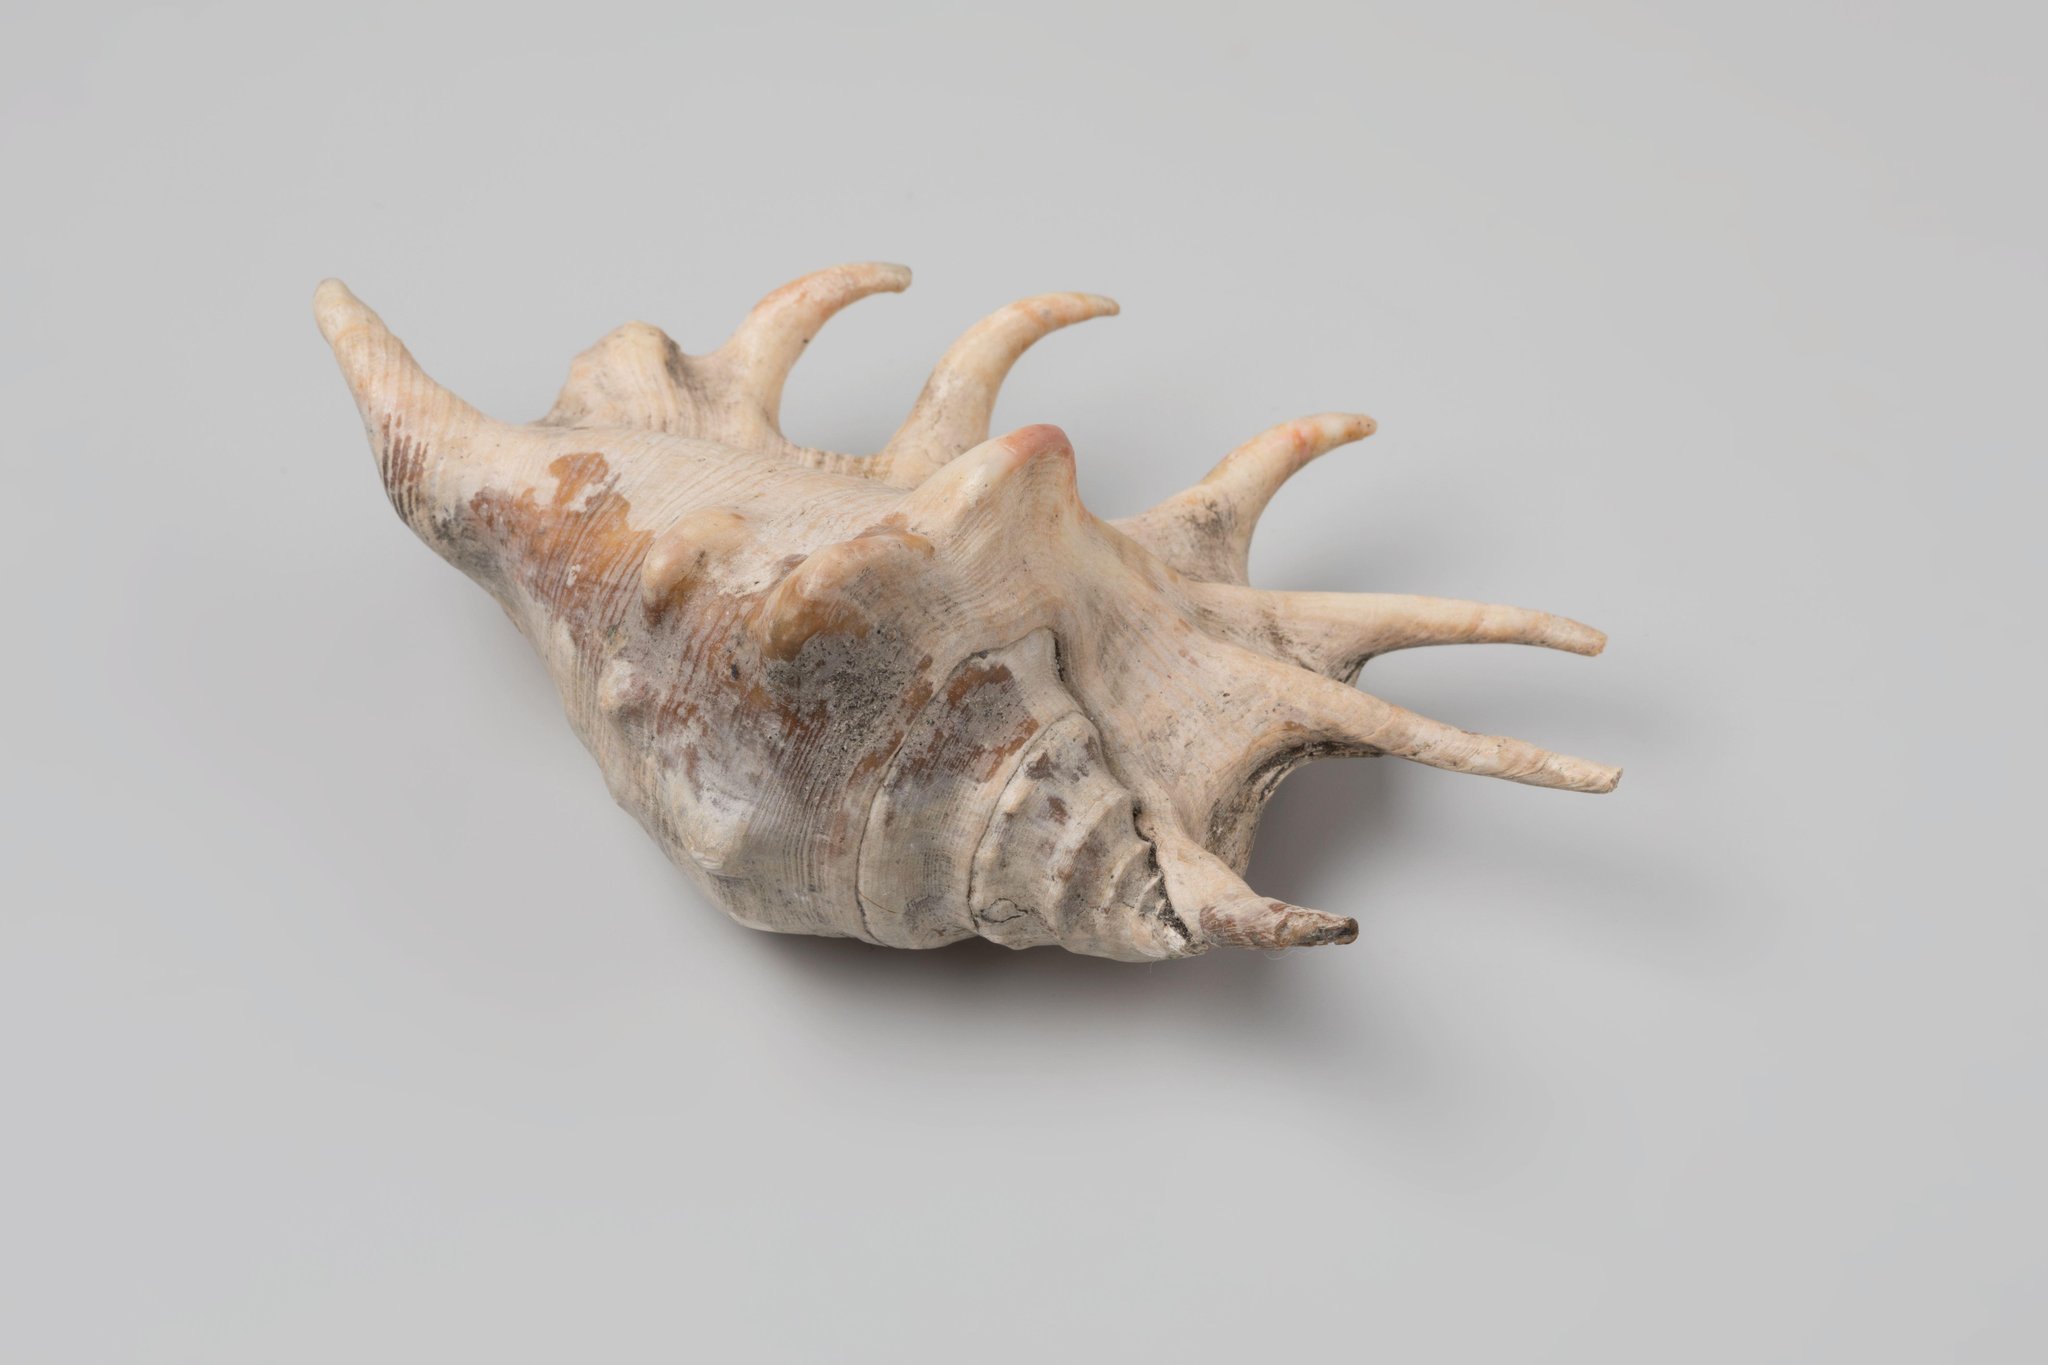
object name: lambis lambis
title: Lambis lambis shell from the wreck of the Dutch East India ship Witte Leeuw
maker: niet van toepassing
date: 1613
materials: shell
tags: verenigde oostindische compagnie, sint-helena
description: Schelp uit V.O.C.-schip de 'Witte Leeuw'. Eén van vijf schelpen.